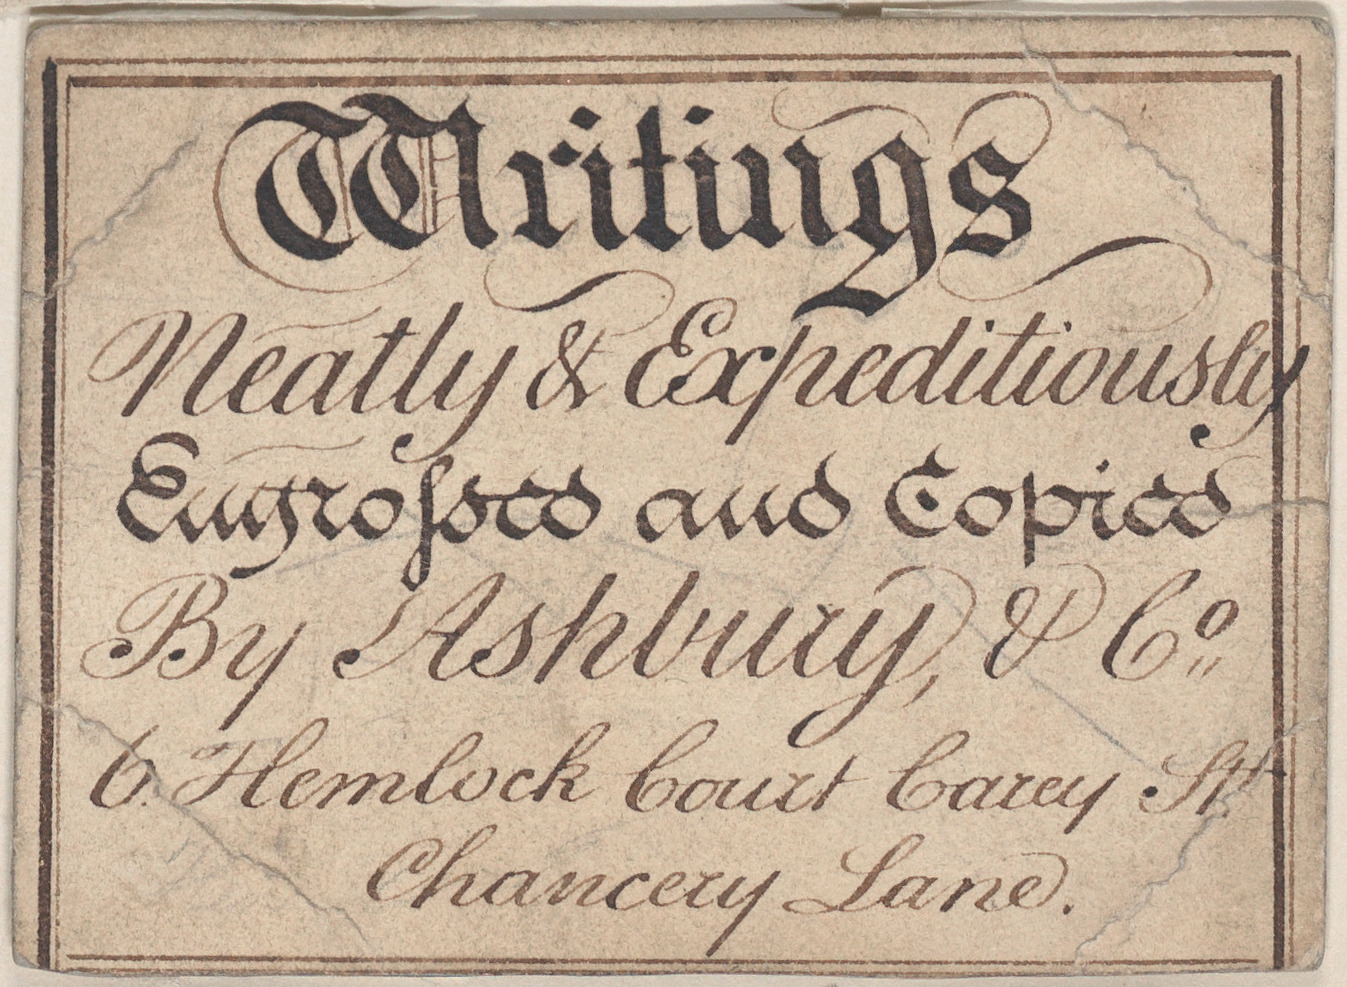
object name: print, trade card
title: Trade Card for Ashbury & Co., Printer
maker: anonymous, british, 19th century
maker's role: artist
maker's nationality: british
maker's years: 1800-1900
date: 1801-1900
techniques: engraving